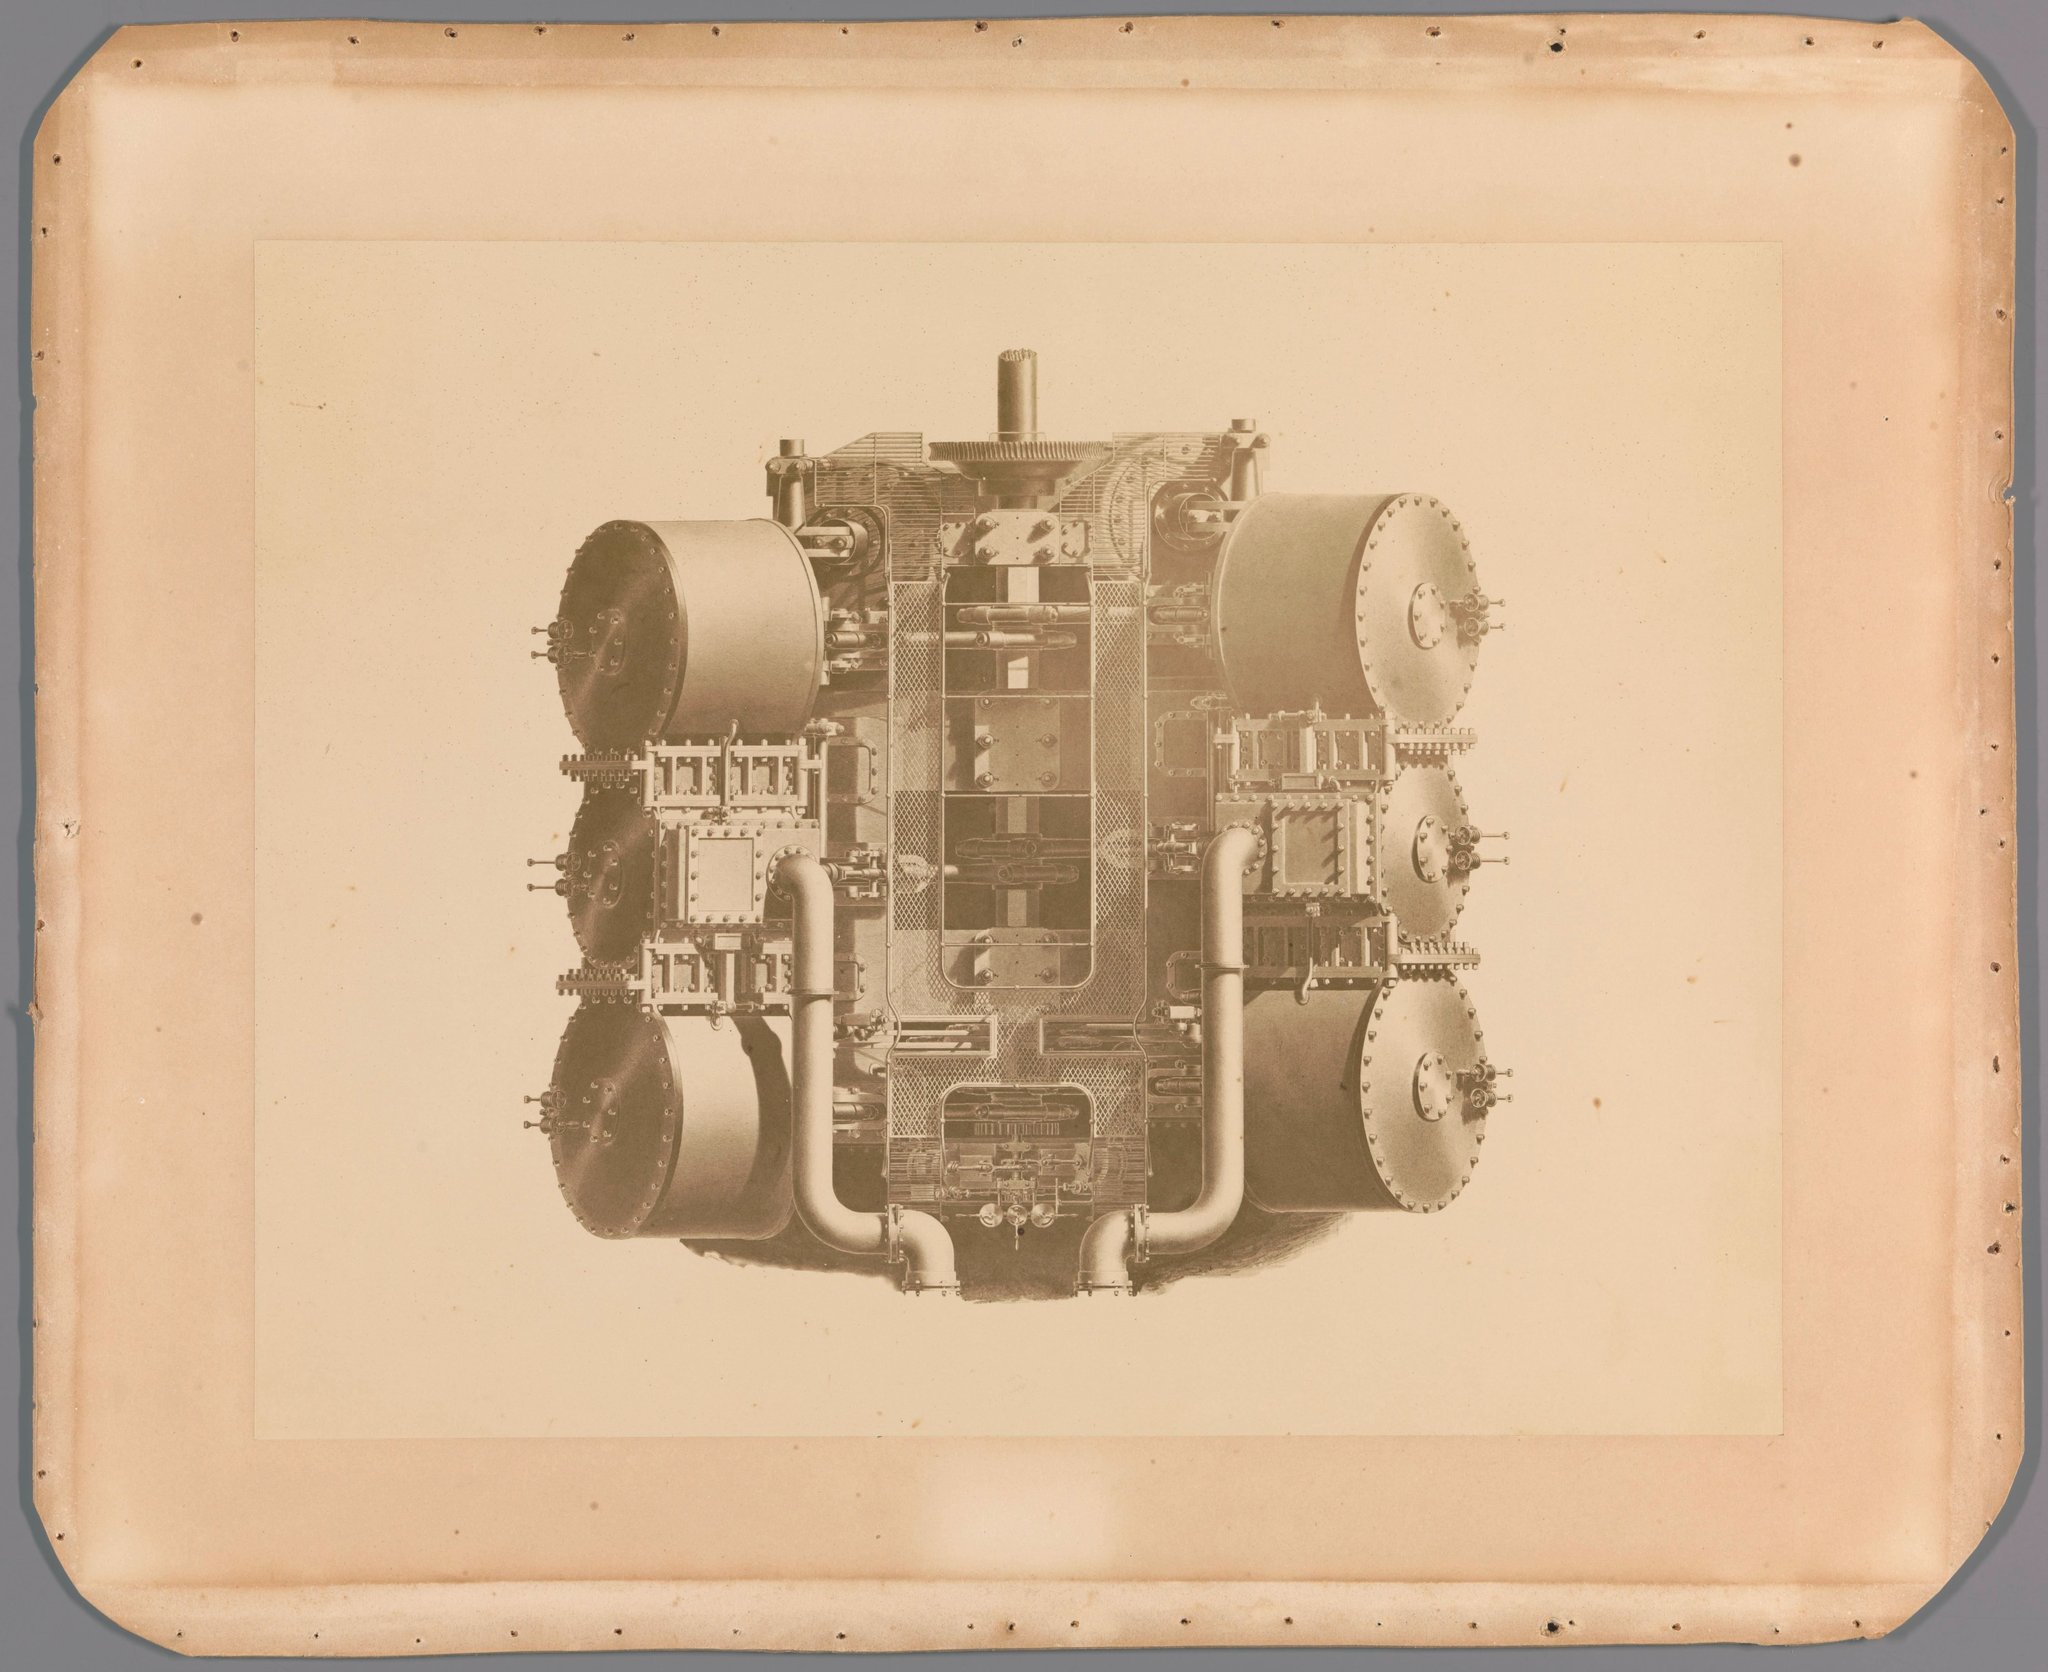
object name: photograph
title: View of a Steam Engine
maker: Anonymous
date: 1870-1880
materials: paper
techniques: photolithography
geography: france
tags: engineer, henry dupuy de lôme, france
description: Afbeelding van een dubbele drie cylinder diagonale stoommachine, ontworpen door de Franse ingenieur Henry Dupuy de Lôme, van bovenaf gezien.